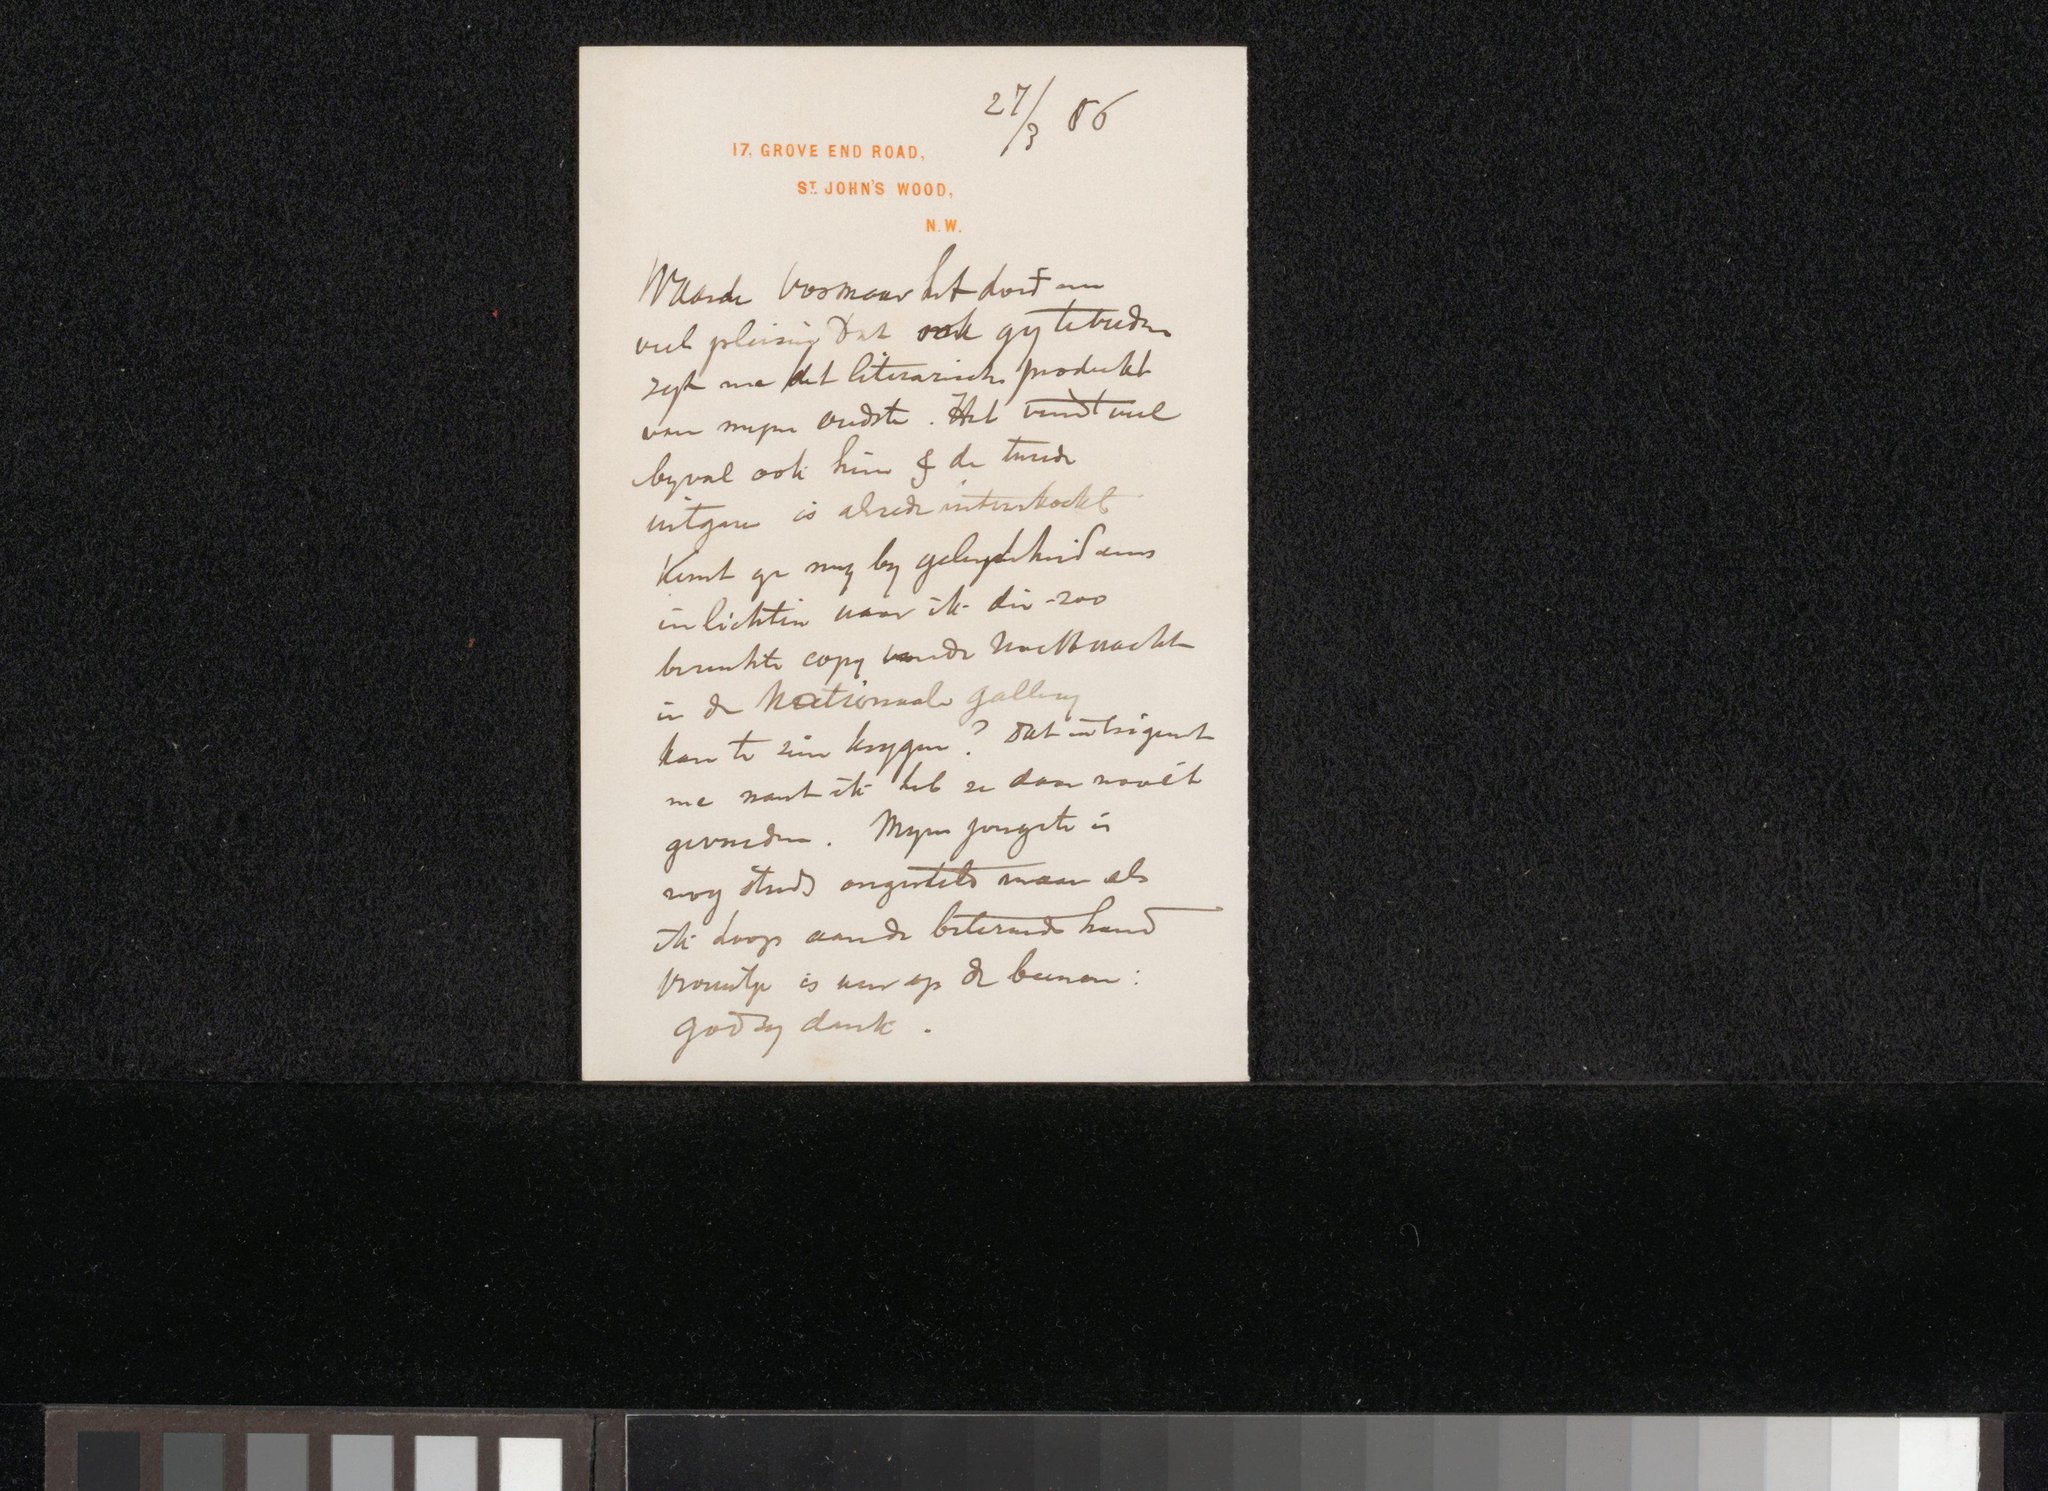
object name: letter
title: Brief aan Carel Vosmaer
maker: lourens alma tadema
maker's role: draughtsman, print maker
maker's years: 1836-1912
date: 1886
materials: ink, paper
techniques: pen, printing, writing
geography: london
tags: carel vosmaer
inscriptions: watermark